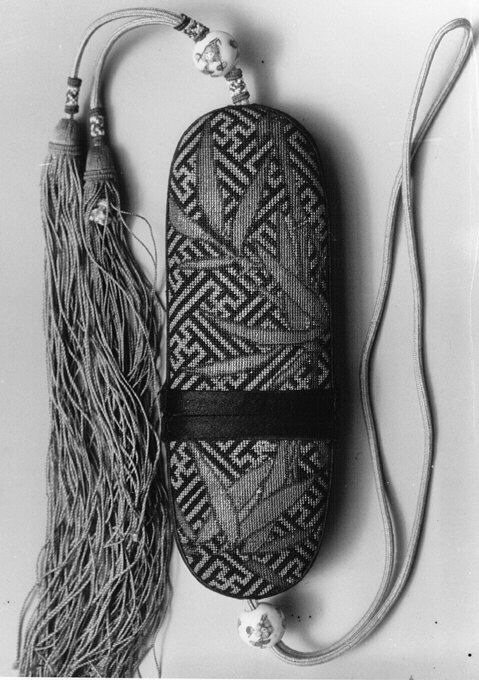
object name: eyeglass case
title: Eyeglasses Case with Bamboo on Fretwork Background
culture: chinese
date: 1701-1900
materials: textile, metal thread, silk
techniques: embroidery